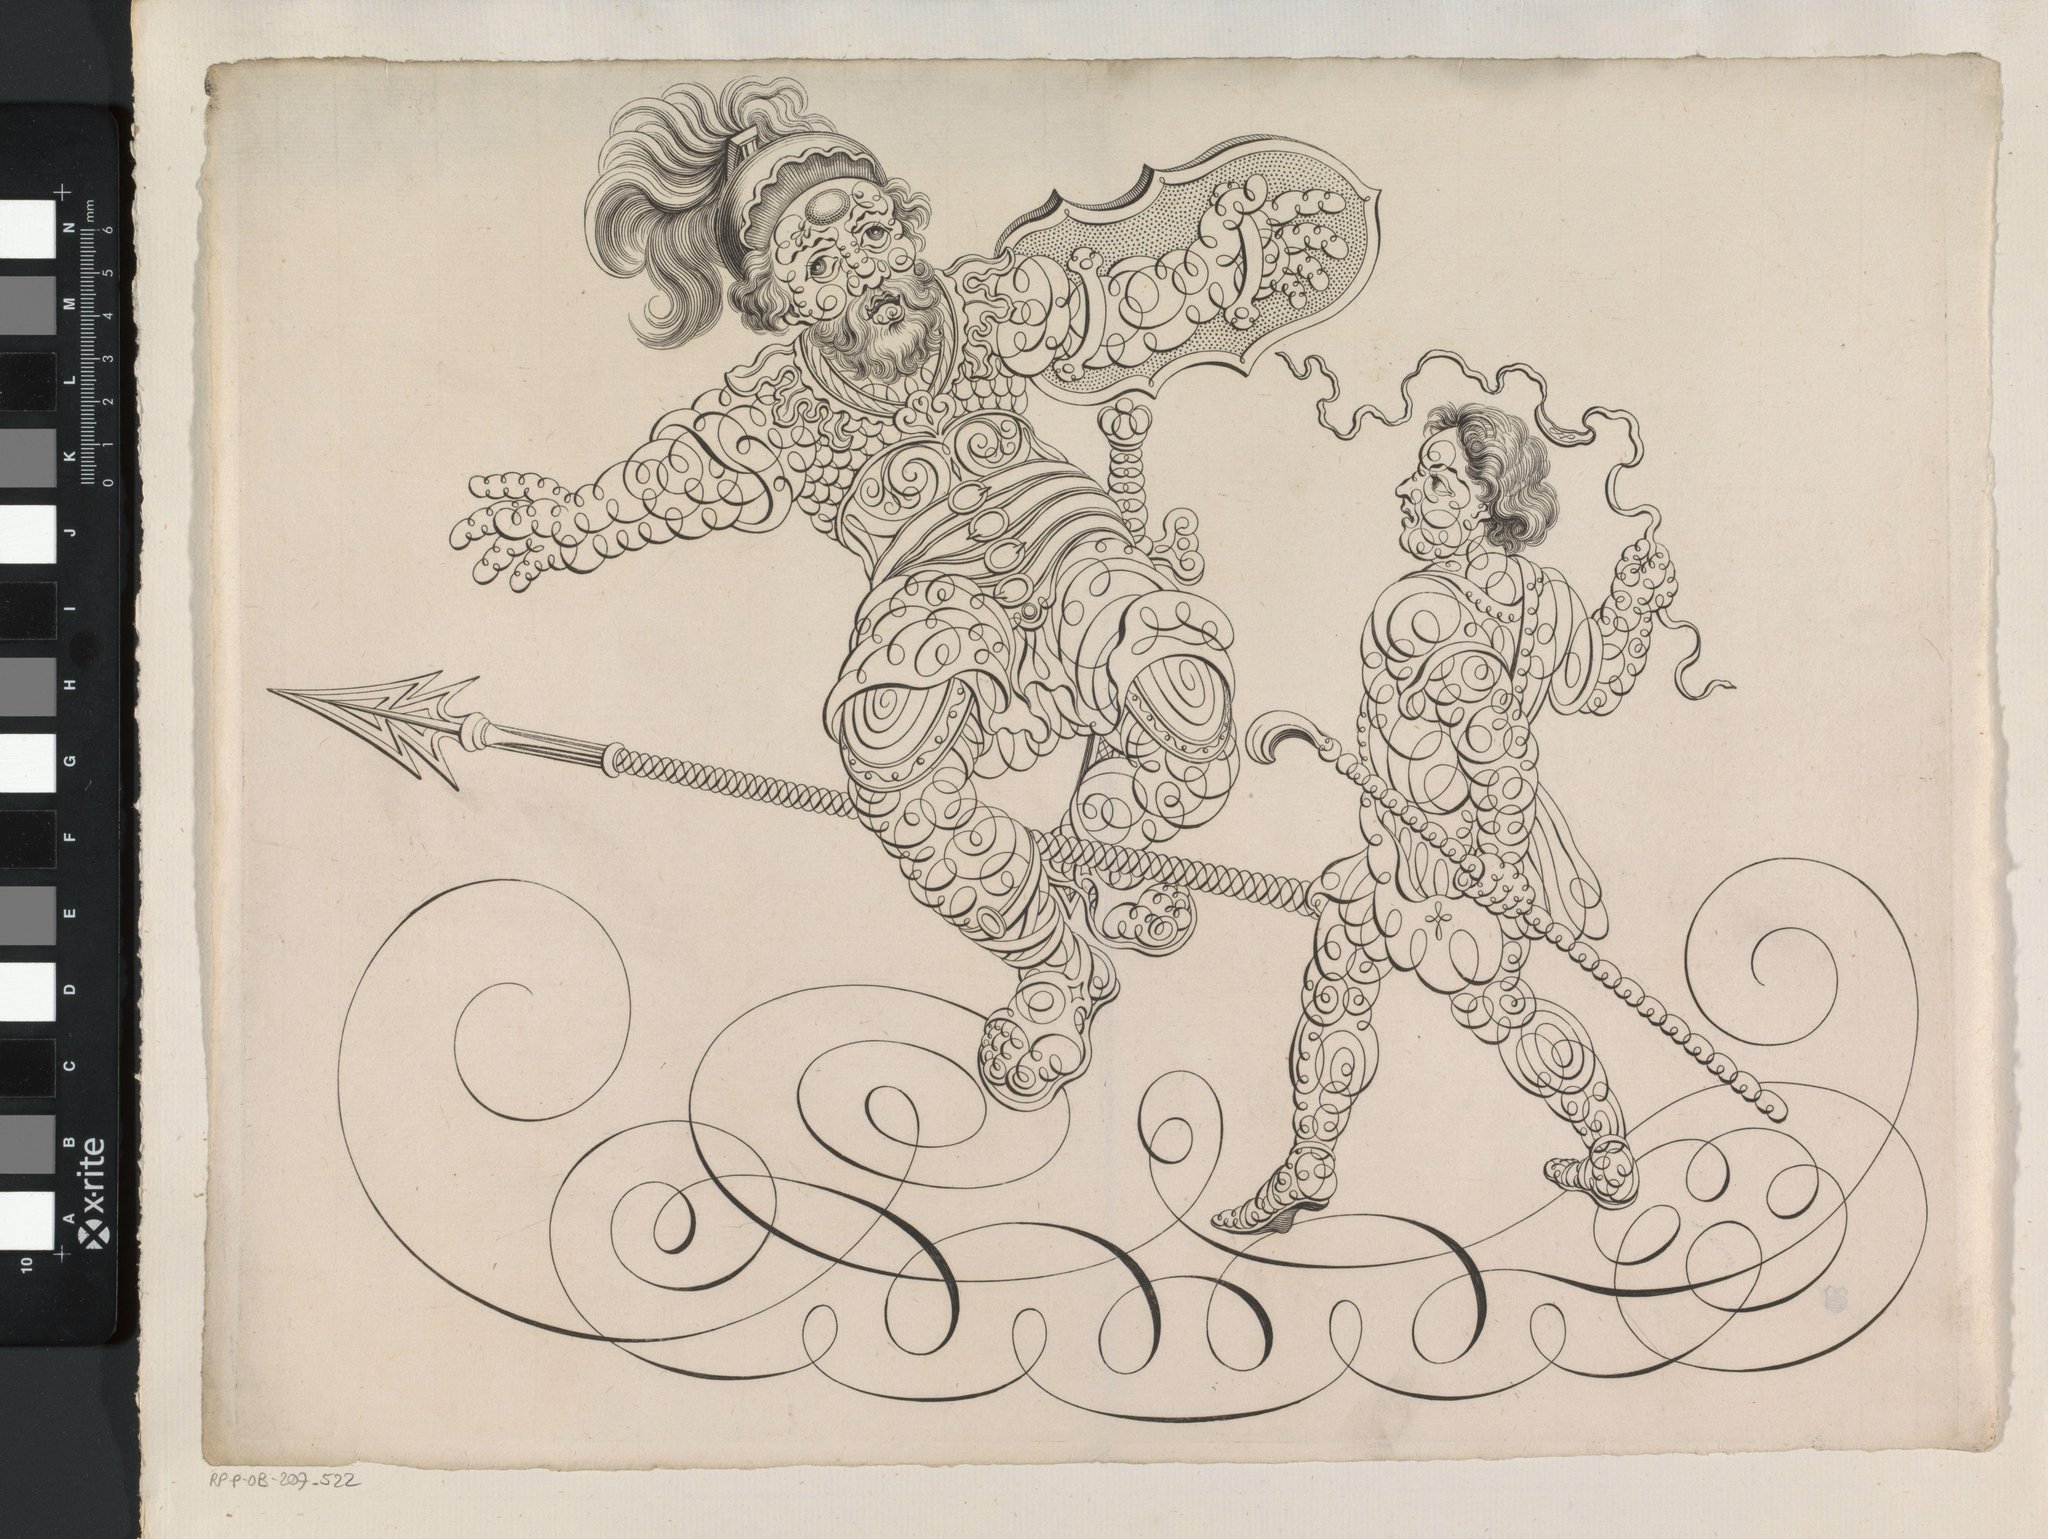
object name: print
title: David en Goliat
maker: Anonymous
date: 1700-1899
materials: paper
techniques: etching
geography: netherlands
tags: david fighting goliath, weapons, fighting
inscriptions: collector's mark: Lugt 2760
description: Het gevecht tussen David en Goliat. De figuren en hun wapens bestaan grotendeels uit krullen (kalligrafie).